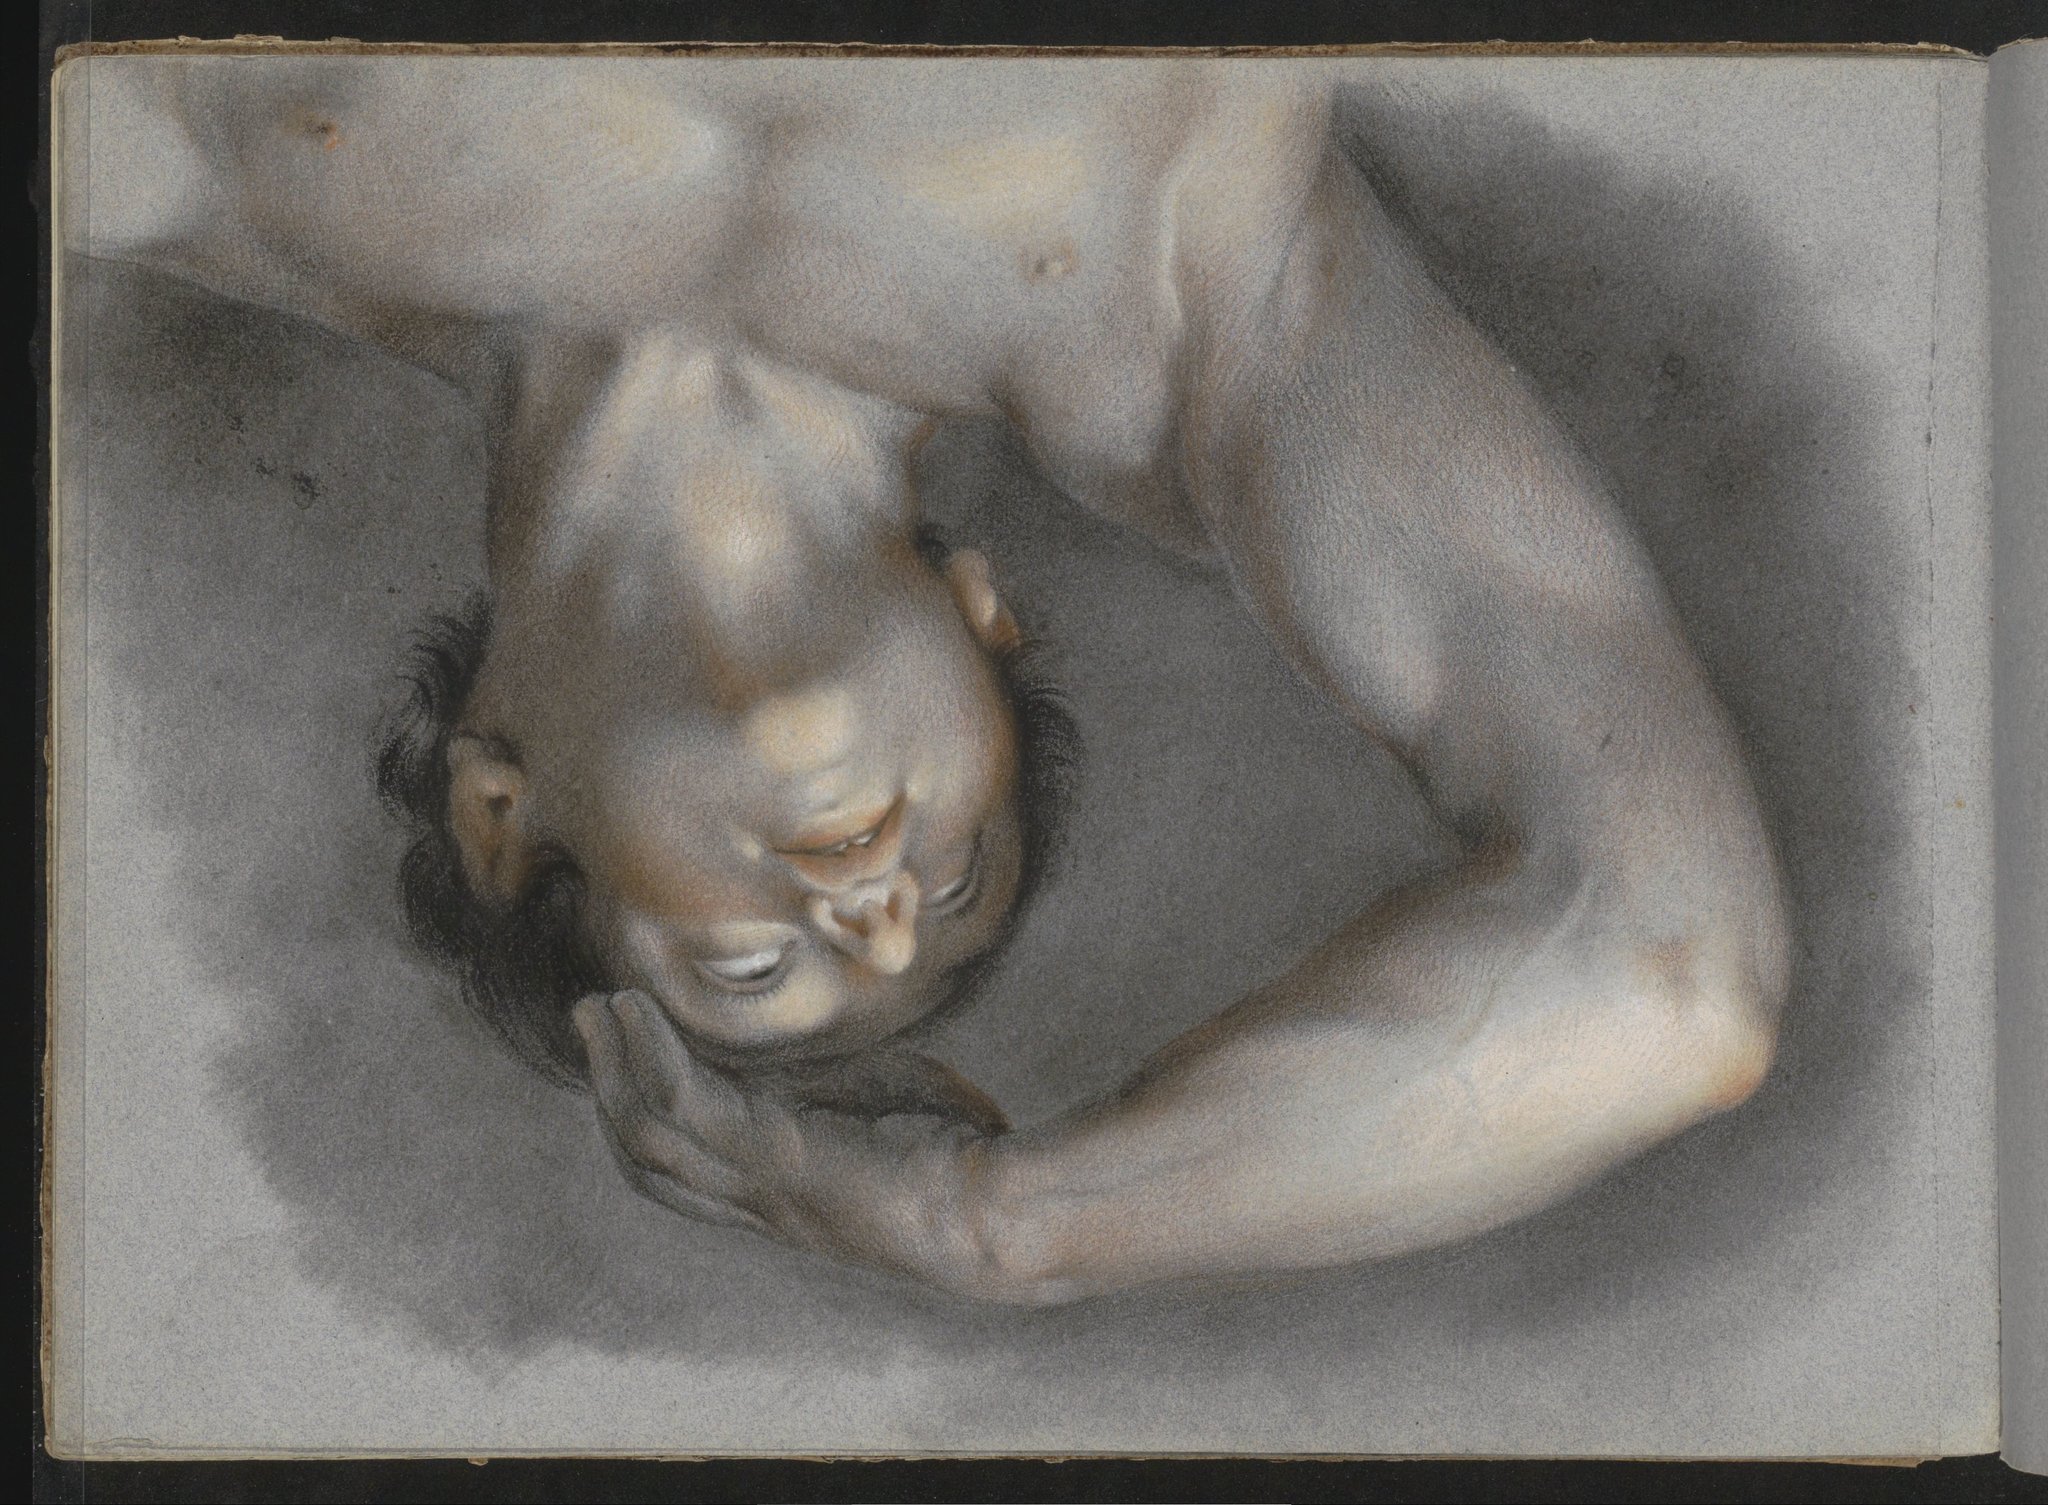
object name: sketchbook leaf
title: Opwaarts kijkende naakte man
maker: s. altmann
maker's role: painter, print maker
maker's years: 1822-1890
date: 1803-1840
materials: chalk, paper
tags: hand towards the forehead, the (nude) human figure; 'corpo humano' (ripa), looking upwards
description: De man raakt met de rechterhand zijn voorhoofd aan. Blad 21 verso uit een schetsboek met 24 bladen.